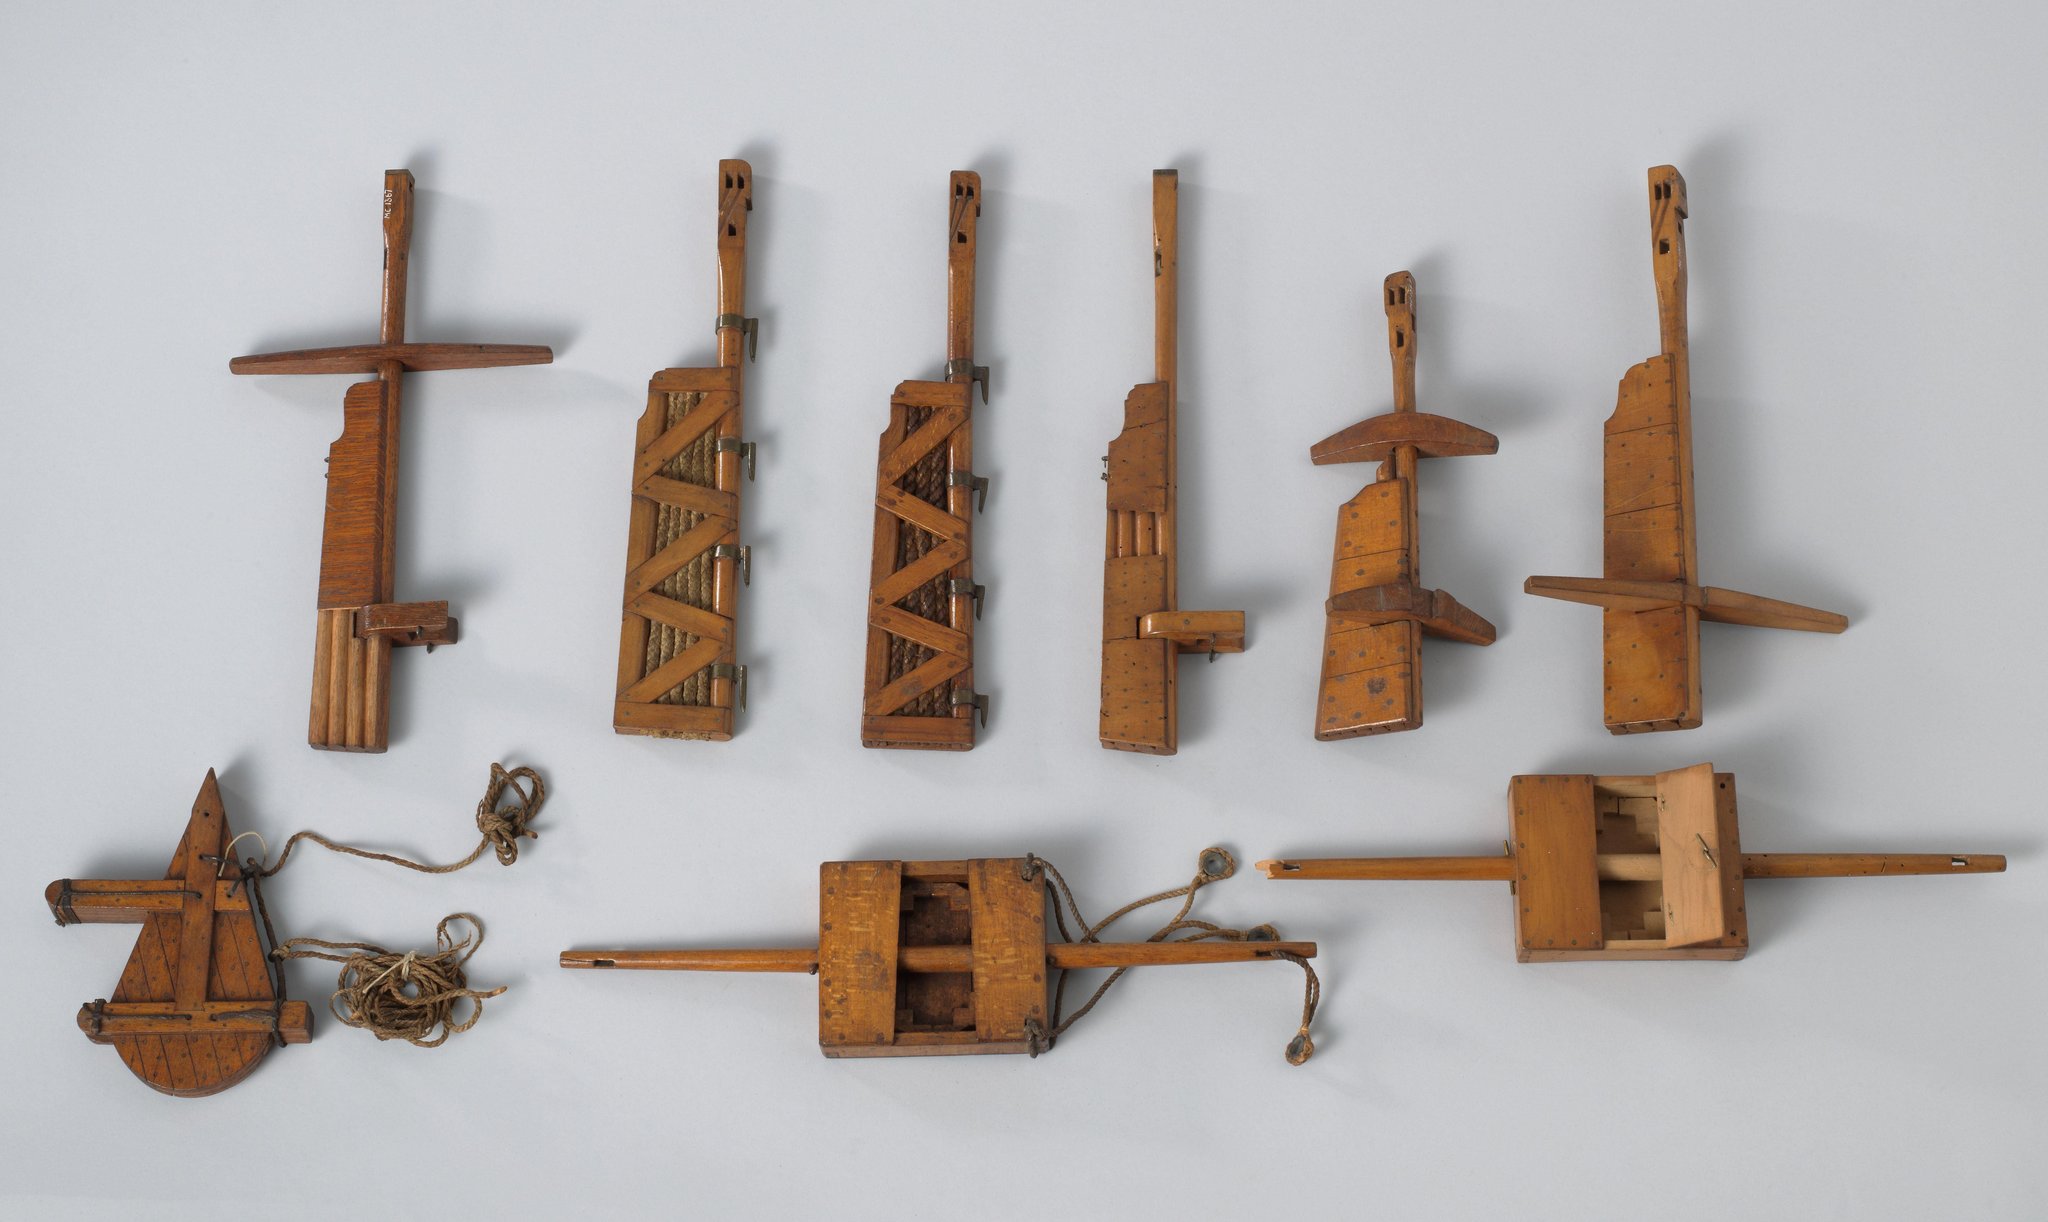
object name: demonstration model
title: Model of a Jury Rudder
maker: Anonymous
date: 1820-1870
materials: brass, wood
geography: netherlands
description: Negen modellen van noodroeren. Drie noodroeren (nrs. 1-3) zijn bijna identiek aan de modellen NG-MC-228, 229 en 230. Ze hebben een steng als roerkoning en het roerblad is samengesteld uit rondhouten met planken bedekt. Twee daarvan (nrs. 1-2) hebben een ezelshoofd als roerhaak om de koning, bij de derde is hiervoor een ankerstok gebruikt. Eén noodroer (nr. 2) heeft een ankerstok om de roerkop, vergelijkbaar met model NG-MC-229 (Pakenhams noodroer). Het vierde model is een kleinere versie van dit type noodroer en heeft twee korte ankerstokken om de koning, een als roerhaak en een om de roerkop. Twee bijna identieke modellen (nrs. 5-6) zijn noodroeren met een steng als roerkoning en het roerblad is samengesteld uit trossen die door planken bijeen worden gehouden; deze modellen hebben speciale messing roerhaken. Het zevende model, van planken gemaakt, heeft een druppelvorm en is vermoedelijk gebaseerd op het ontwerp van Bassiere. Het laatste paar modellen (nrs. 8-9) bestaat uit een ra waar een kast omheen is gebouwd. De hoeken van de kast zijn aan de binnenkant verstevigd met de wangen van rolpaarden. Eén model (nr. 8) is voorzien van stroppen aan één kant, vermoedelijk voor de bevestiging van stuurtalies.